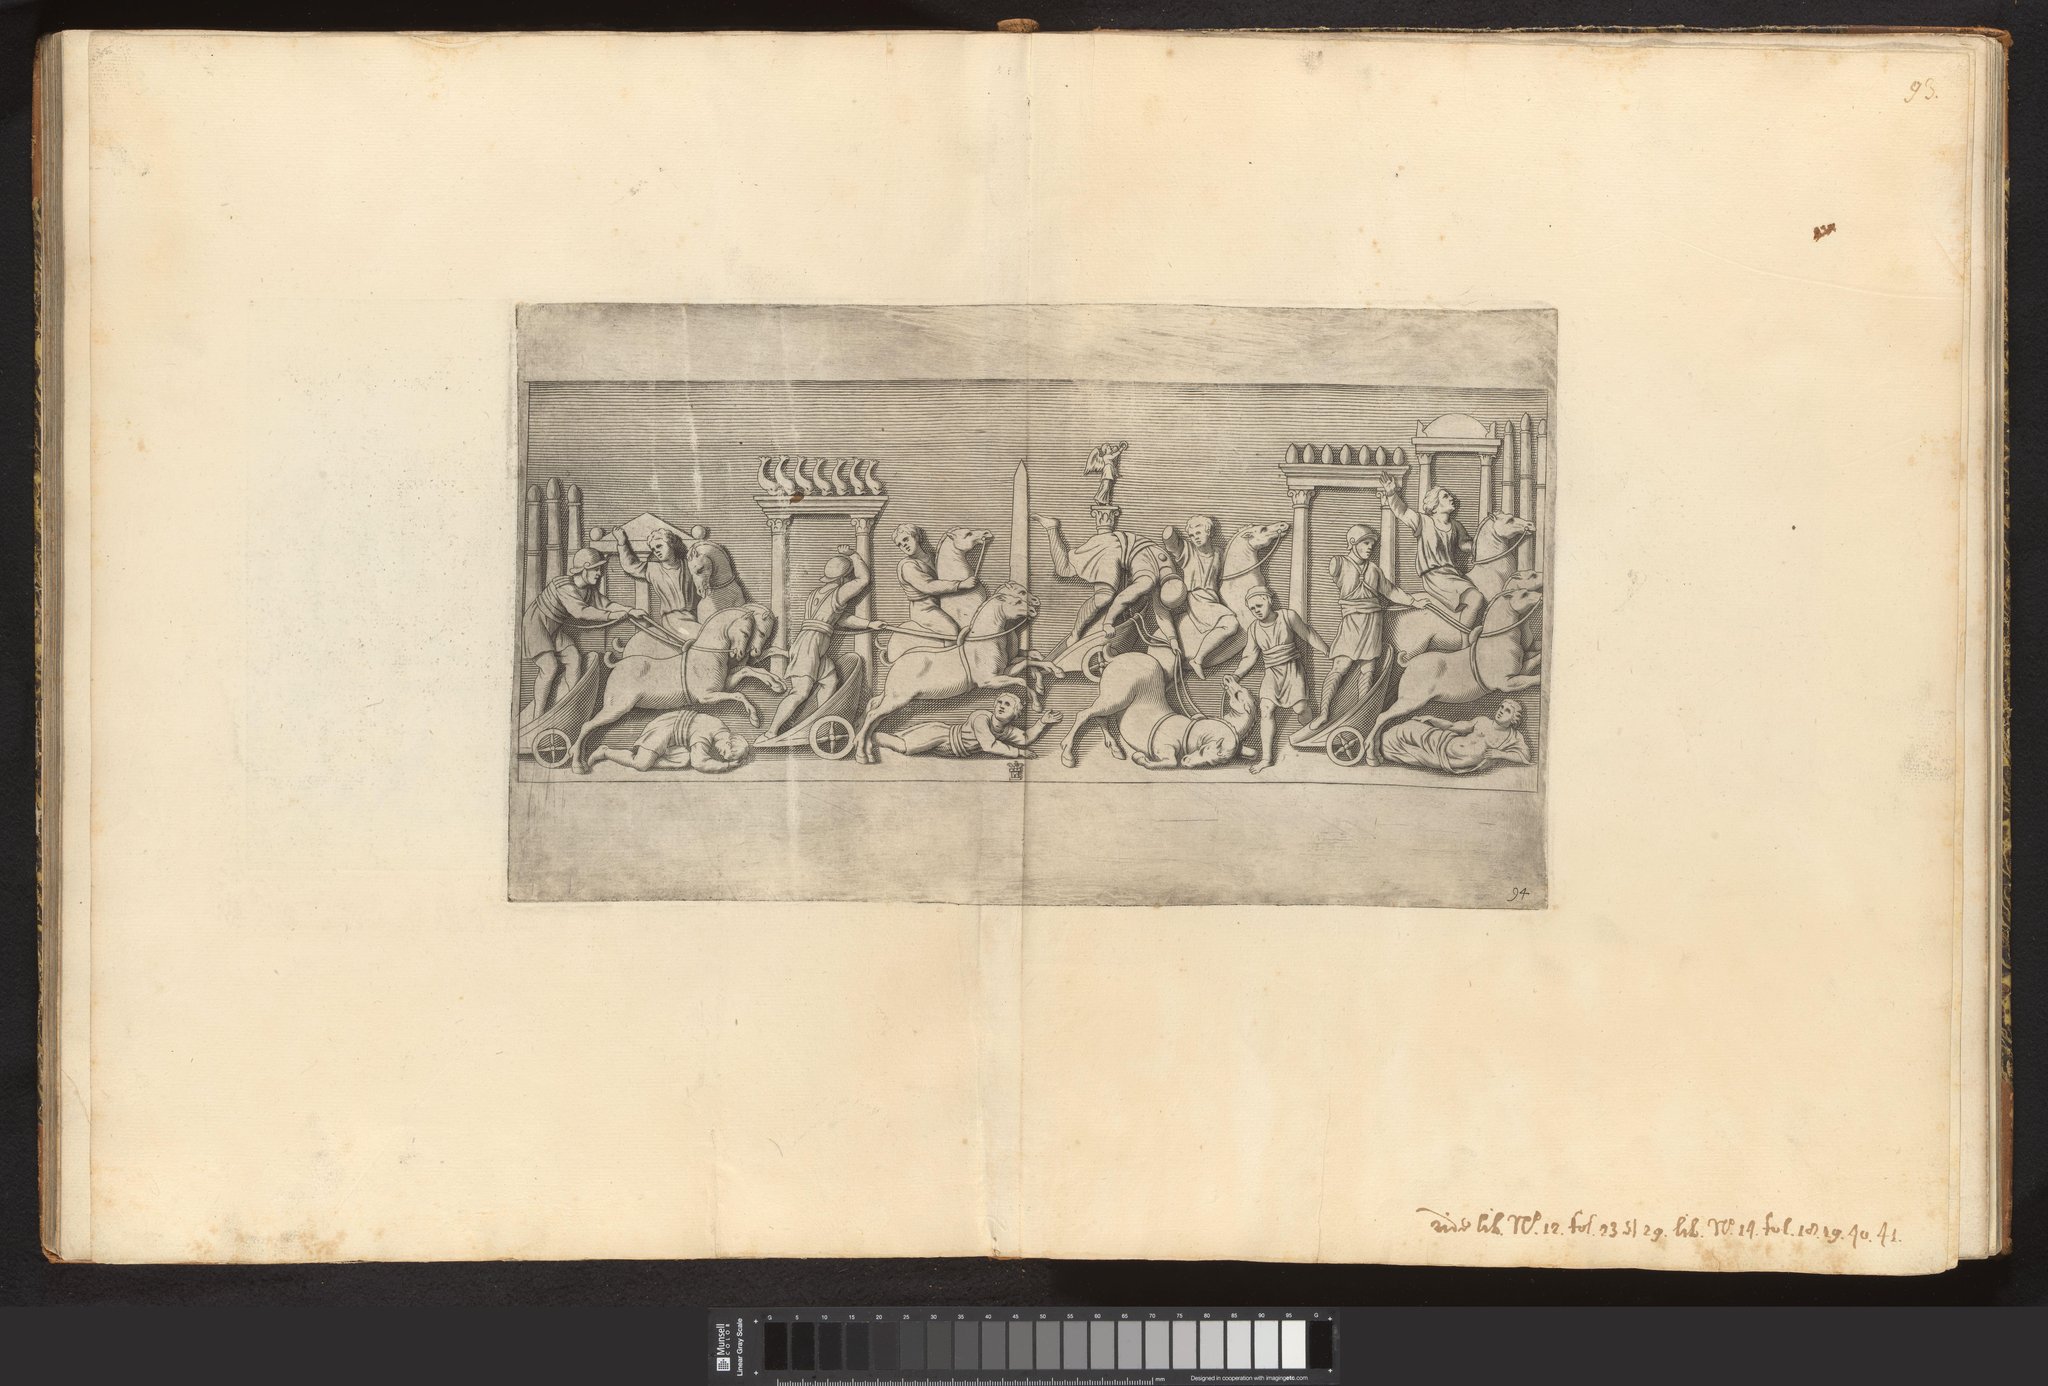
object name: album leaf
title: Galleria Giustiniana del Marchese Vincenzo Giustiniani II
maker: ottavio ora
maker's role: print maker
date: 1636-1647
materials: paper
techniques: engraving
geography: rome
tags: piece of sculpture, reproduction of a piece of sculpture, cupids: 'amores', 'amoretti', 'putti'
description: Romeins bas-reliëf van een groep putti, van wie er twee een portret vasthouden. (Waarschijnlijk een fragment van een sacrcofaag.) Midden onder het wapenschild van Vincenzo Giustiniani. Prent maakt deel uit van een album met een serie prenten naar de sculpturen in de verzameling in de Galleria Giustiniani te Rome.